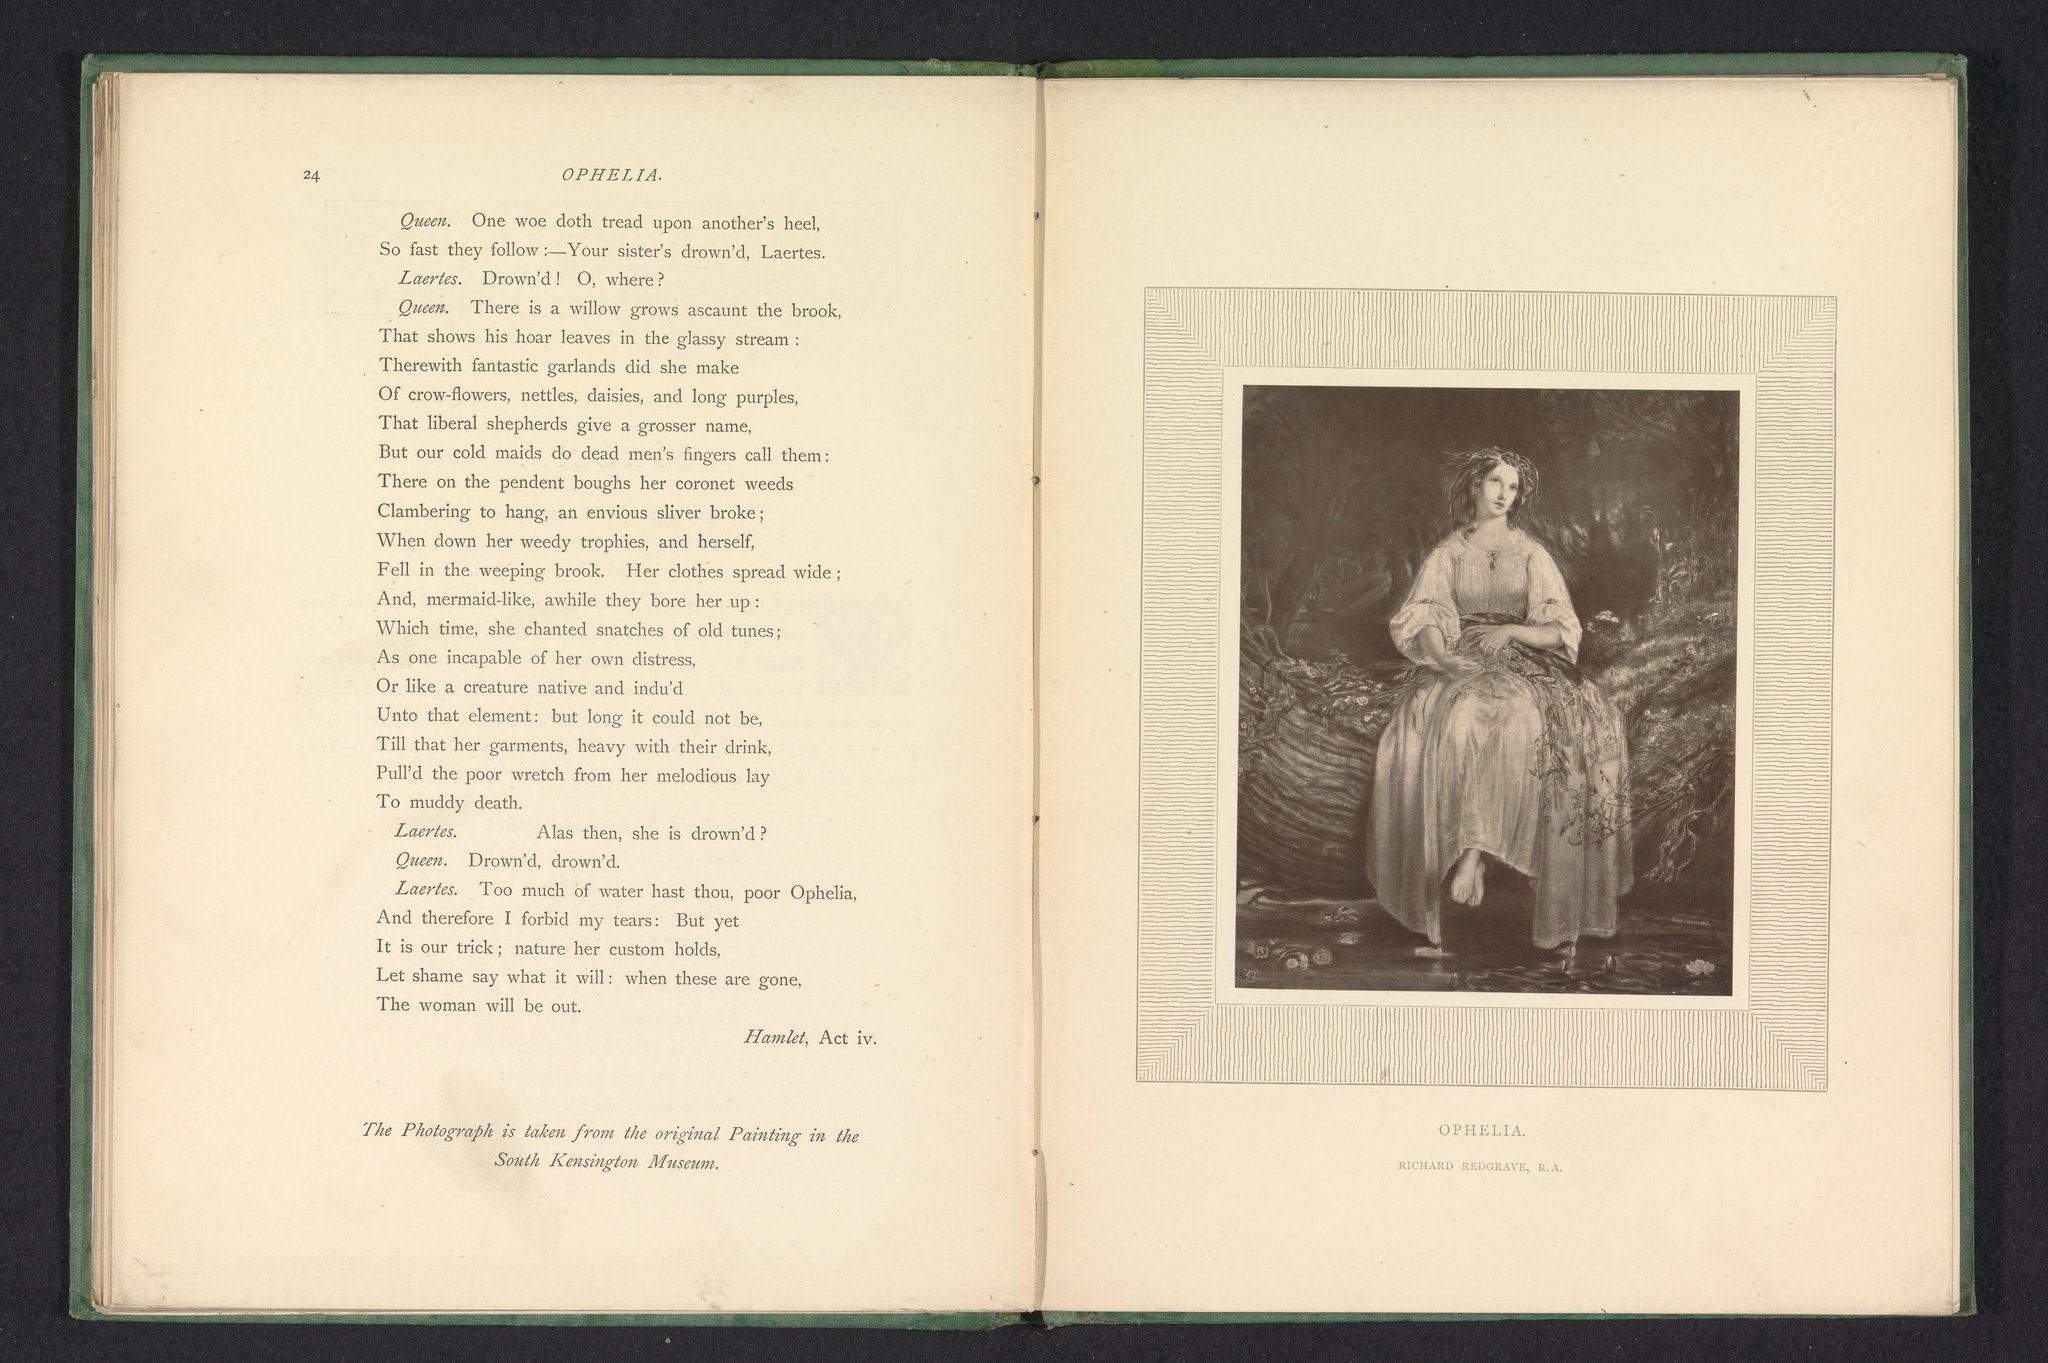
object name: reproduction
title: Ophelia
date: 1863-1873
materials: paper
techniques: woodburytype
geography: london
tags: ophelia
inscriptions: name: ‘Ess[...] 184[...]’